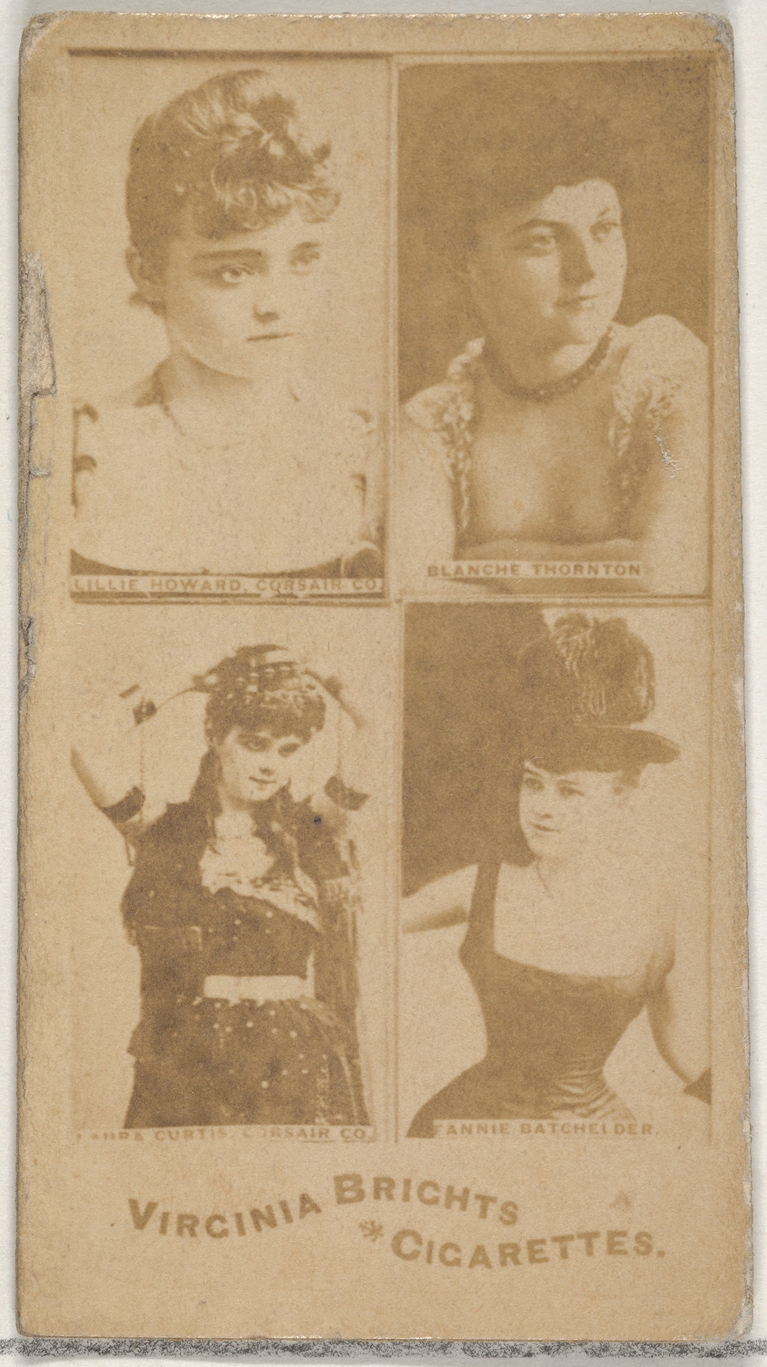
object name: photograph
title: Lillie Howard, Corsair Co./ Blanche Thornton/ Laura Curtis, Corsair Co./ Fannie Batchelder, from the Actors and Actresses series (N45, Type 4) for Virginia Brights Cigarettes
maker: allen & ginter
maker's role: publisher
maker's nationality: american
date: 1888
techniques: albumen silver print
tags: portraits,women,actresses